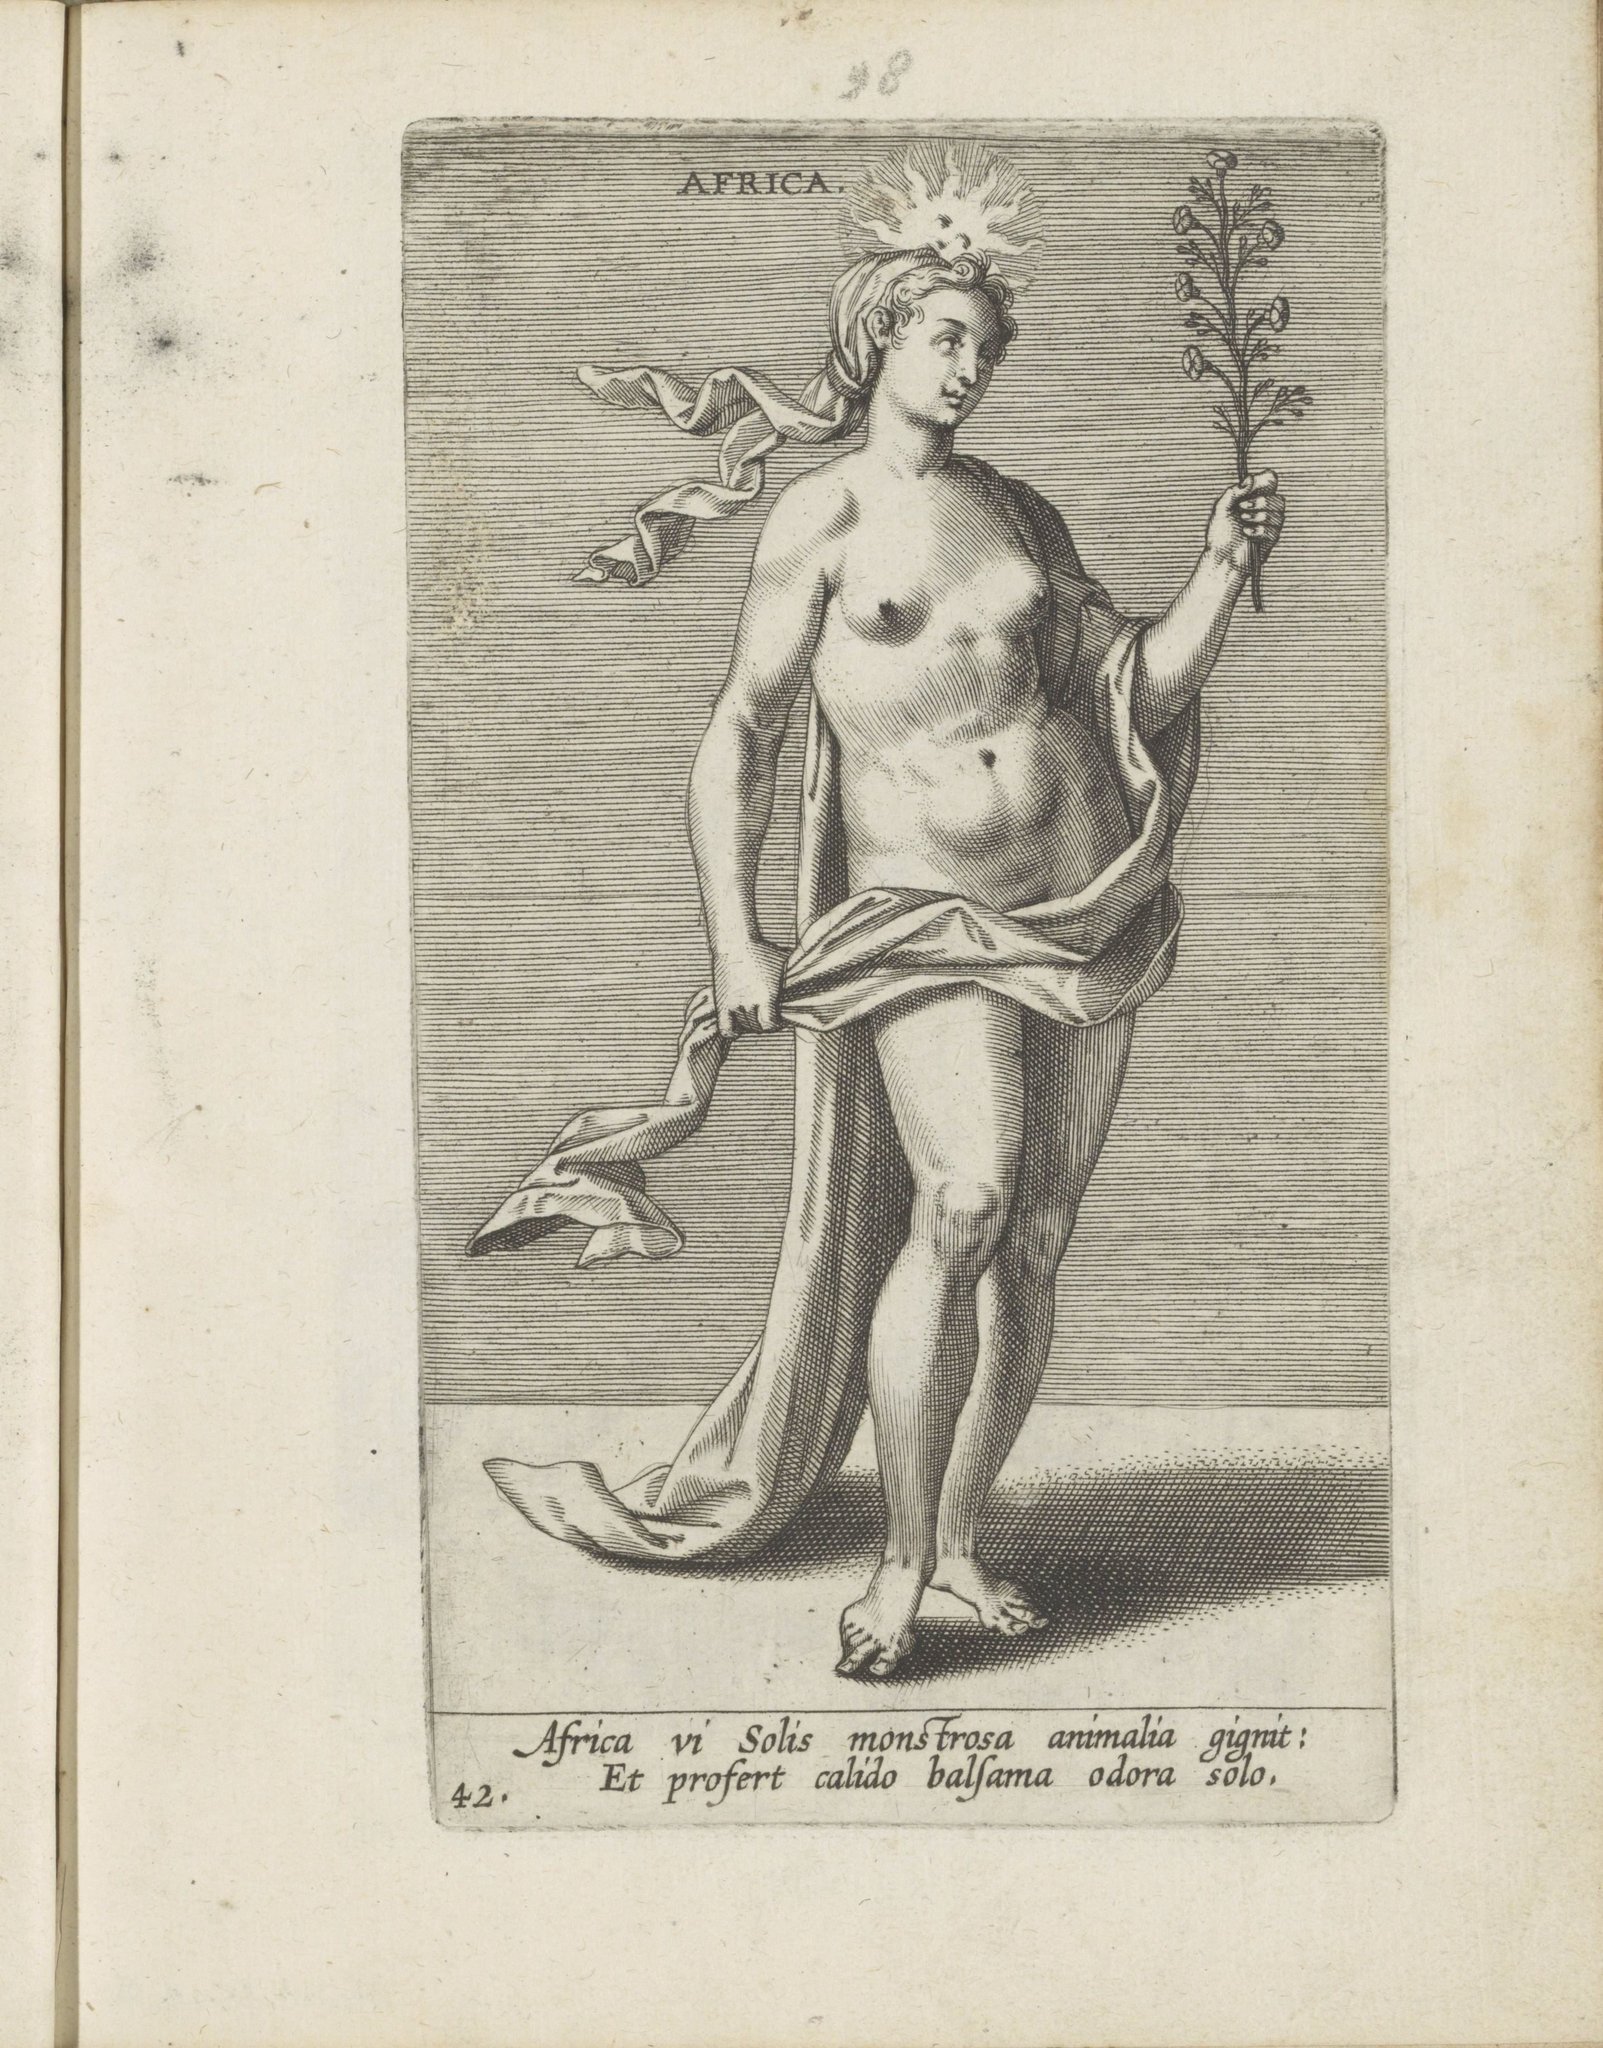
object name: album leaf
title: Prosopographia, sive virtutum, animi, corporis, bonorum externorum, vitiorum, et affectuum variorum delineatio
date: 1585-1590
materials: paper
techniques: engraving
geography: southern netherlands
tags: africa represented allegorically; 'africa' (ripa)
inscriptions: collector's mark: Lugt 2760, collector's mark: Lugt 2228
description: Een naakte vrouw met enkel een kleed om haar lichaam gedrapeerd en een doek om haar haren gebonden. Achter haar hoofd straalt de zon. In haar linkerhand heeft zij een bloementak. Onder de voorstelling twee regels tekst in het Latijn. De prent maakt deel uit van een album.